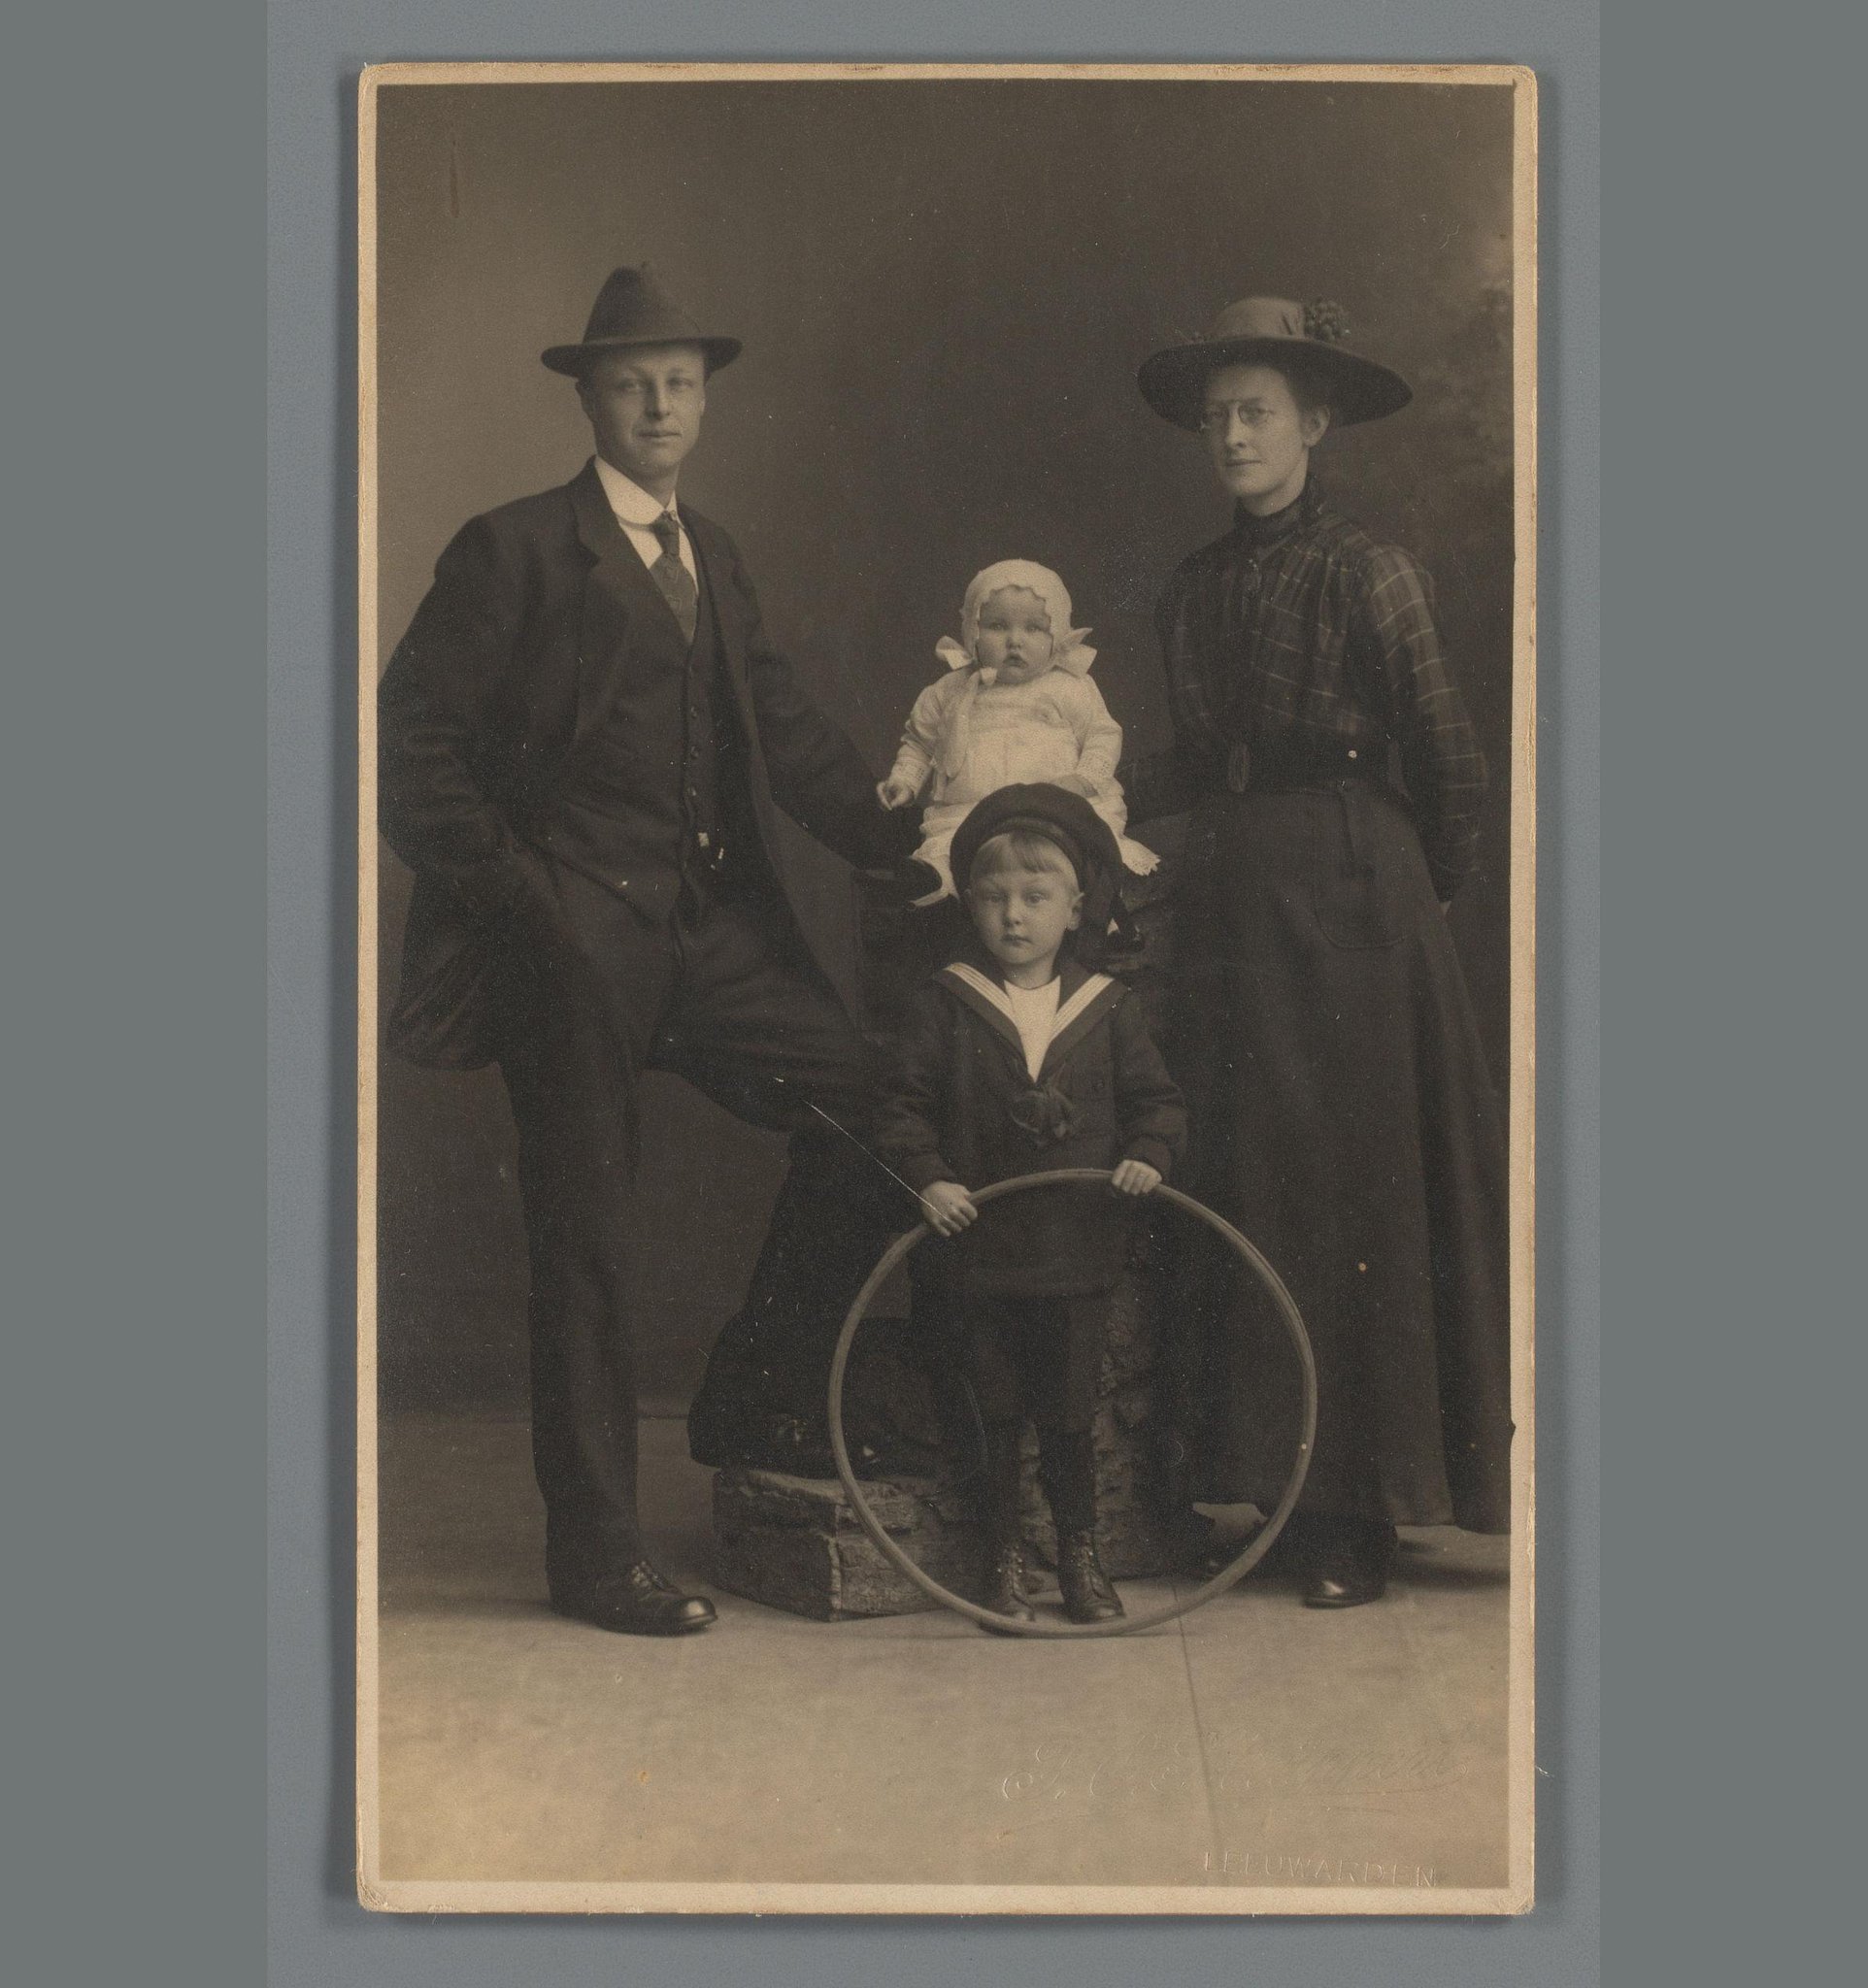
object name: ansichtkaart, prentbriefkaart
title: Groepsportret van een onbekende familie met twee kinderen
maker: friedrich otto strüppert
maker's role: fotograaf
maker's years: 1865-1954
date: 1912-1920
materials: paper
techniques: gelatin silver print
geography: leeuwarden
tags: family group, especially parents with their child(ren), anonymous historical persons portrayed in a group, in a group-portrait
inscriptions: check stamp: ‘F.O. Strüppert/ Leeuwarden’